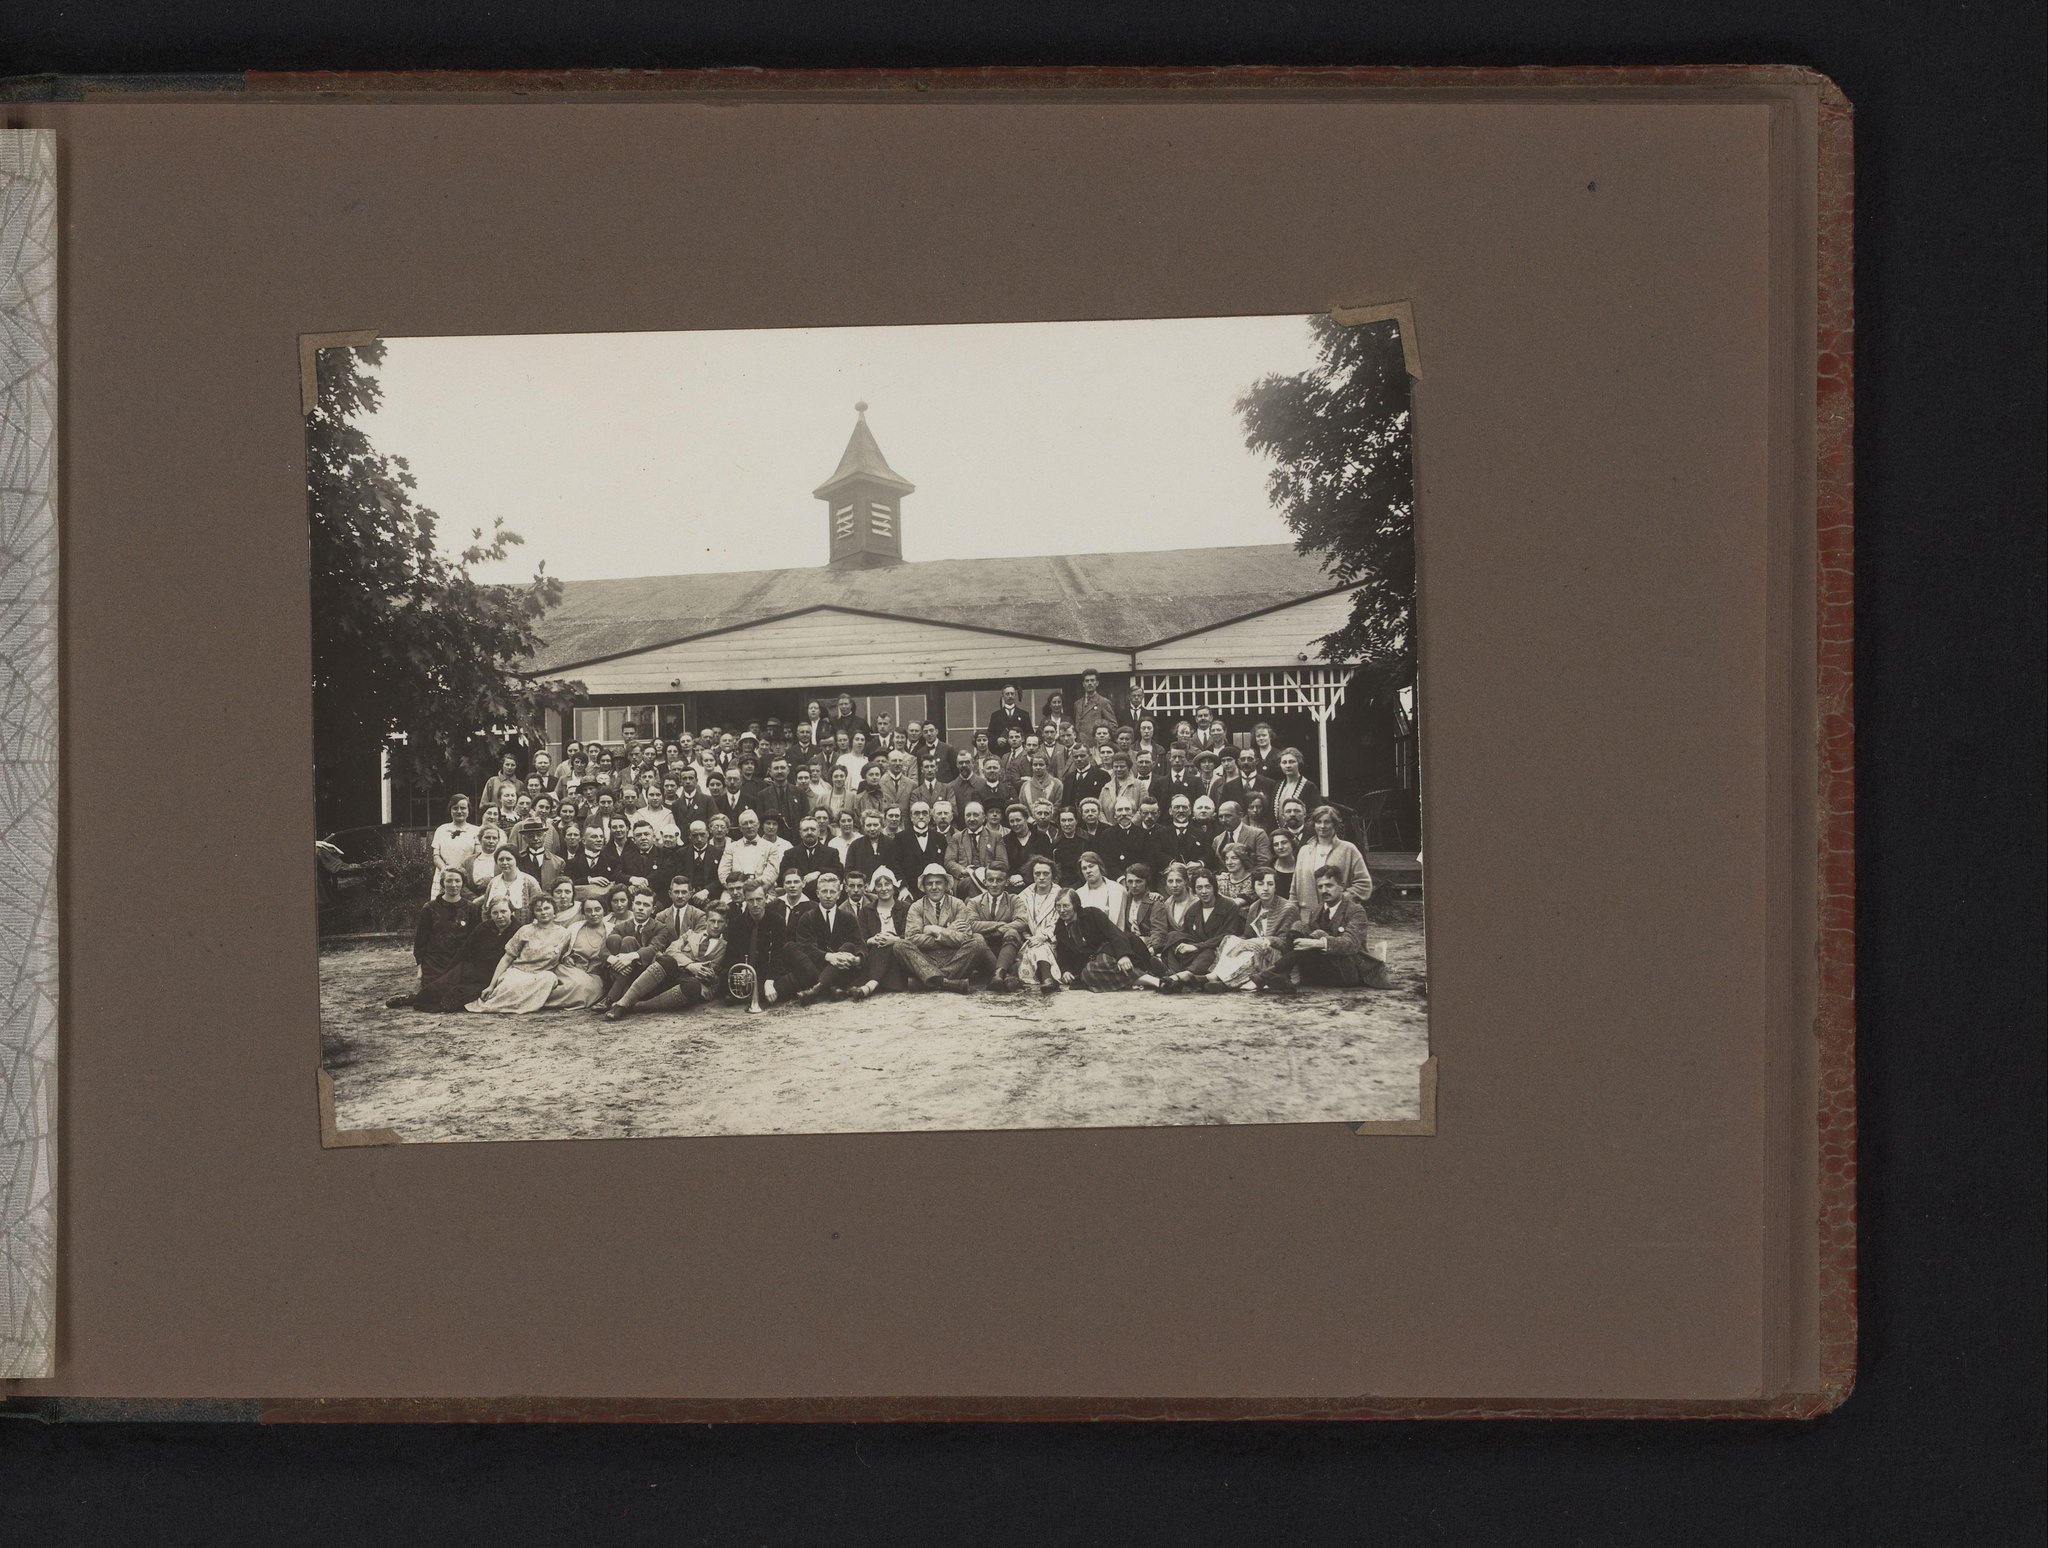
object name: photograph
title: Groepsportret tijdens de Paaschcursus te Ermelo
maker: Anonymous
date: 1927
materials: paper, photographic support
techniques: gelatin silver print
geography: ermelo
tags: anonymous historical persons portrayed in a group, in a group-portrait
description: Deze pagina maakt deel uit van een album.